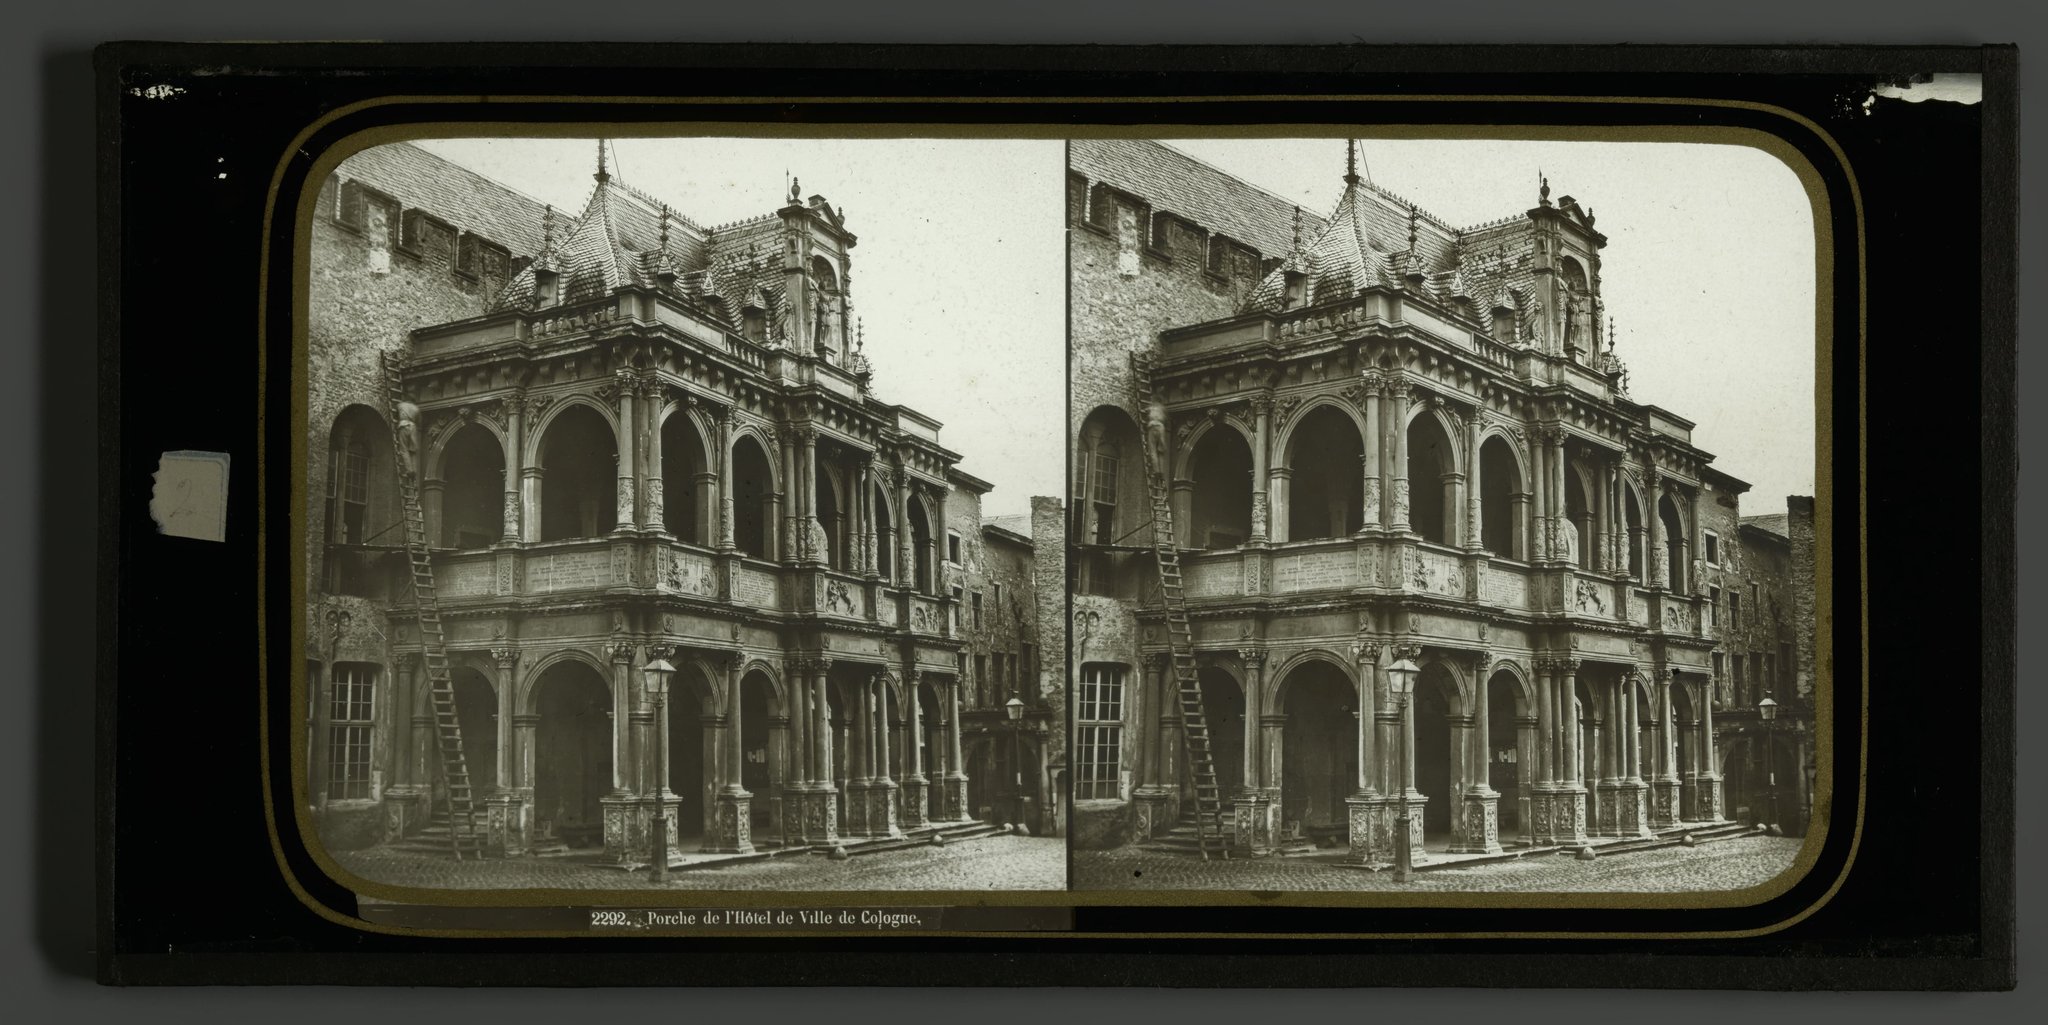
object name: stereoscopic photograph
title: Loggia van het stadhuis van Keulen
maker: ferrier père-fils et soulier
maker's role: publisher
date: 1860-1890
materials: glass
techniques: slide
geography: cologne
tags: townhall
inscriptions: number: ‘2292.’